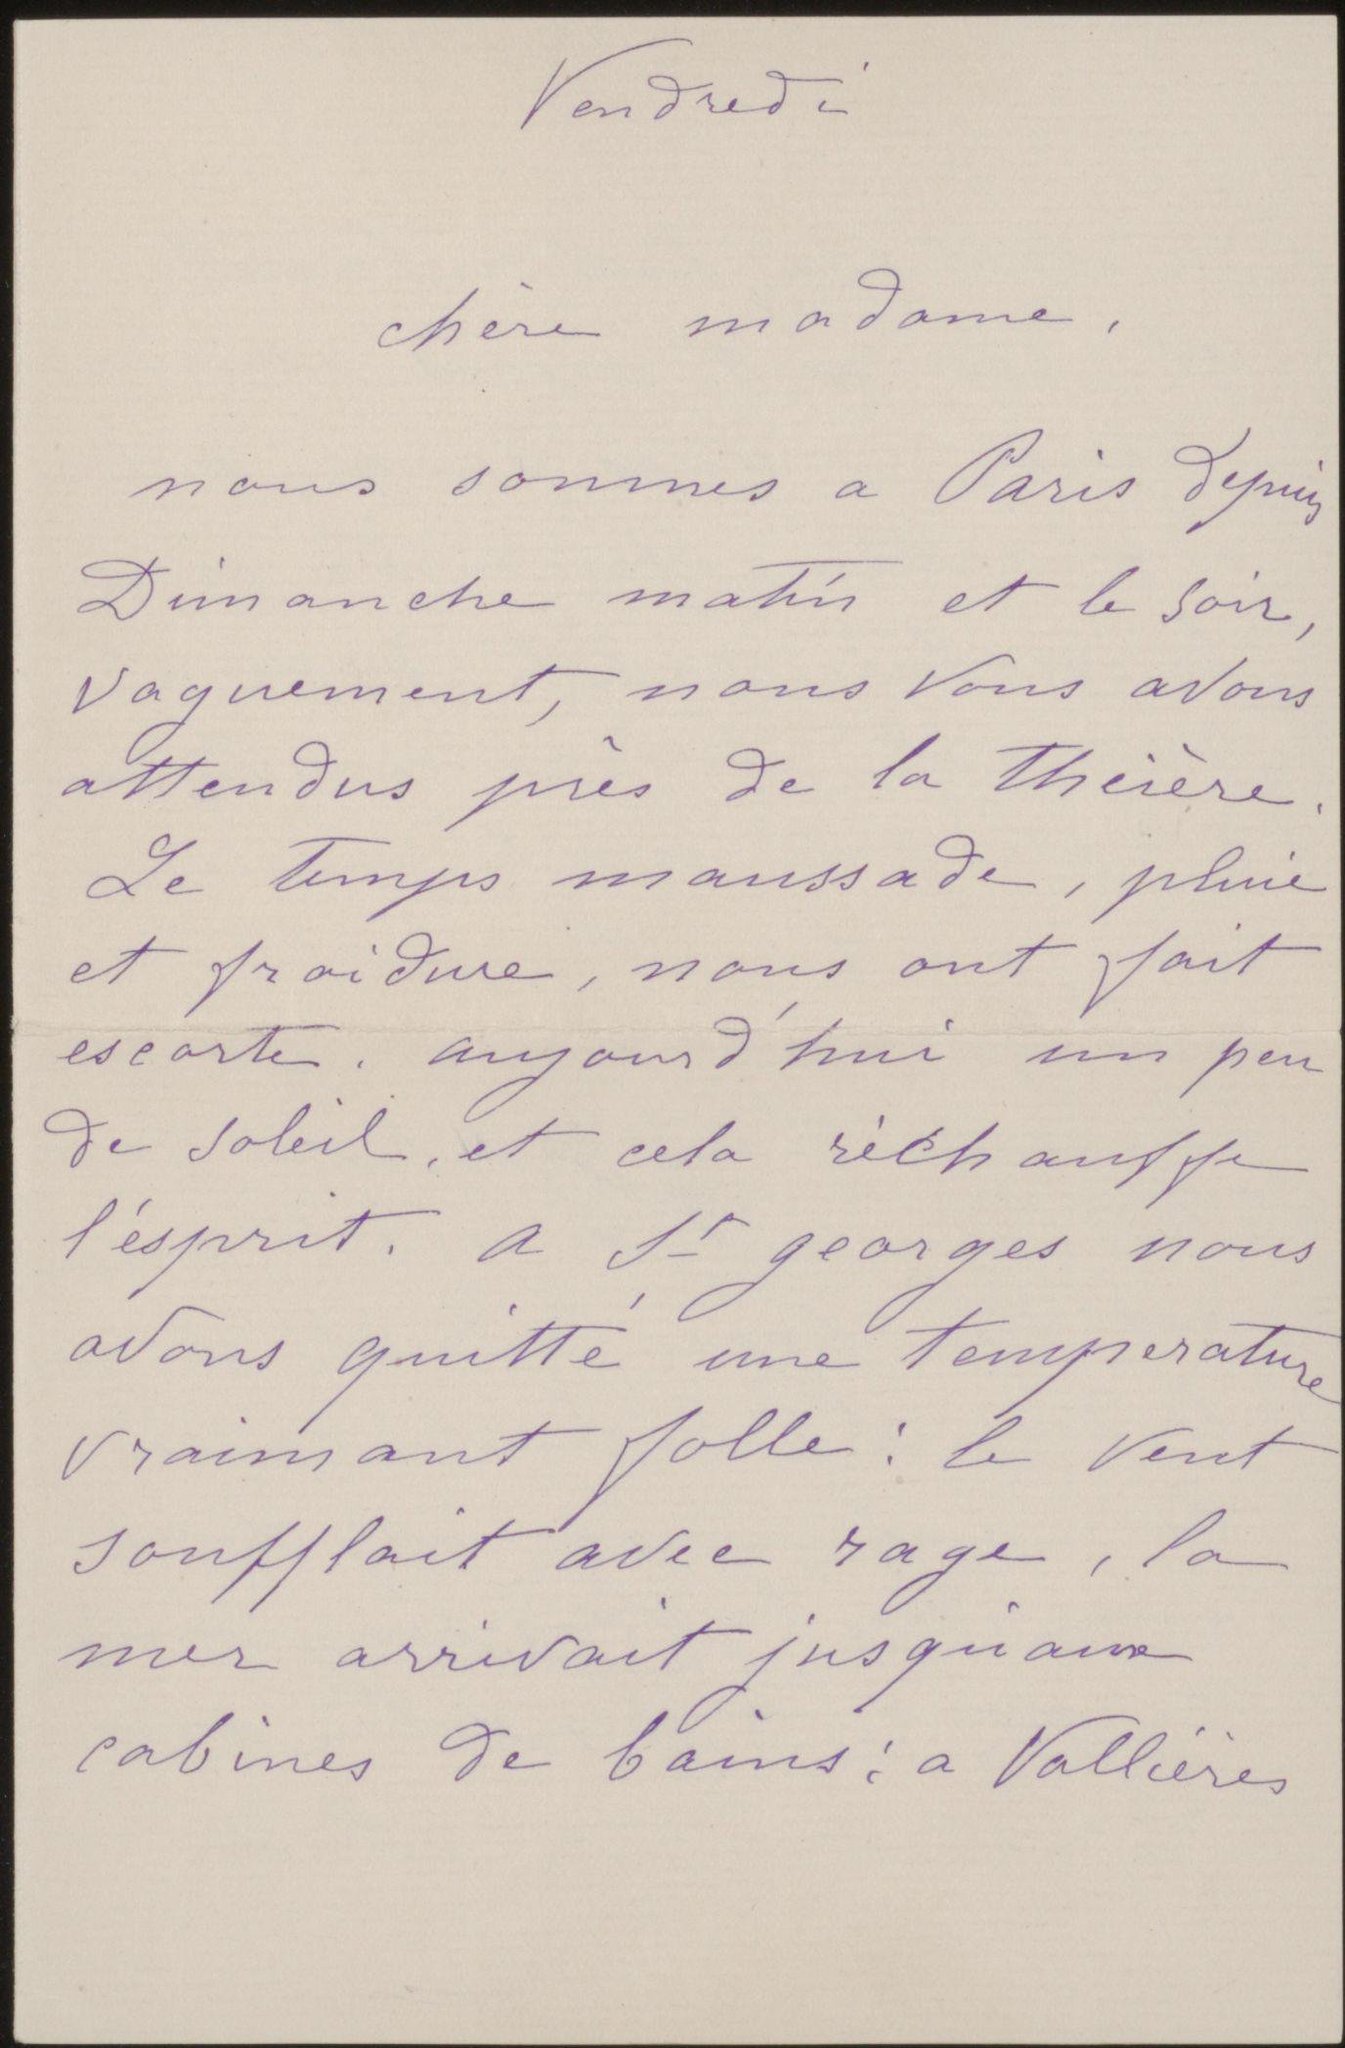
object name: letter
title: Brief aan Anne Marie Louise van der Linden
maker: camille redon-falte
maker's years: 1853-1923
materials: ink, paper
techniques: pen, writing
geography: paris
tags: paris, painter, print maker, draughtsman, odilon redon, drawing, painting (including book-illumination, miniature-painting), exhibition ~ art, historical persons (portraits and scenes from the life)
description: Brief behoort tot een album samengesteld door weduwe Françoise W.M. Barones van der Borch van Verwolde met afschriften van brieven met betrekking tot (de familie van) Odilon Redon. De brief werd bewaard op pagina 89.